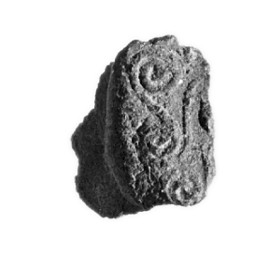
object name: sealing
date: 1981-1640 BCE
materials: mud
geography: egypt